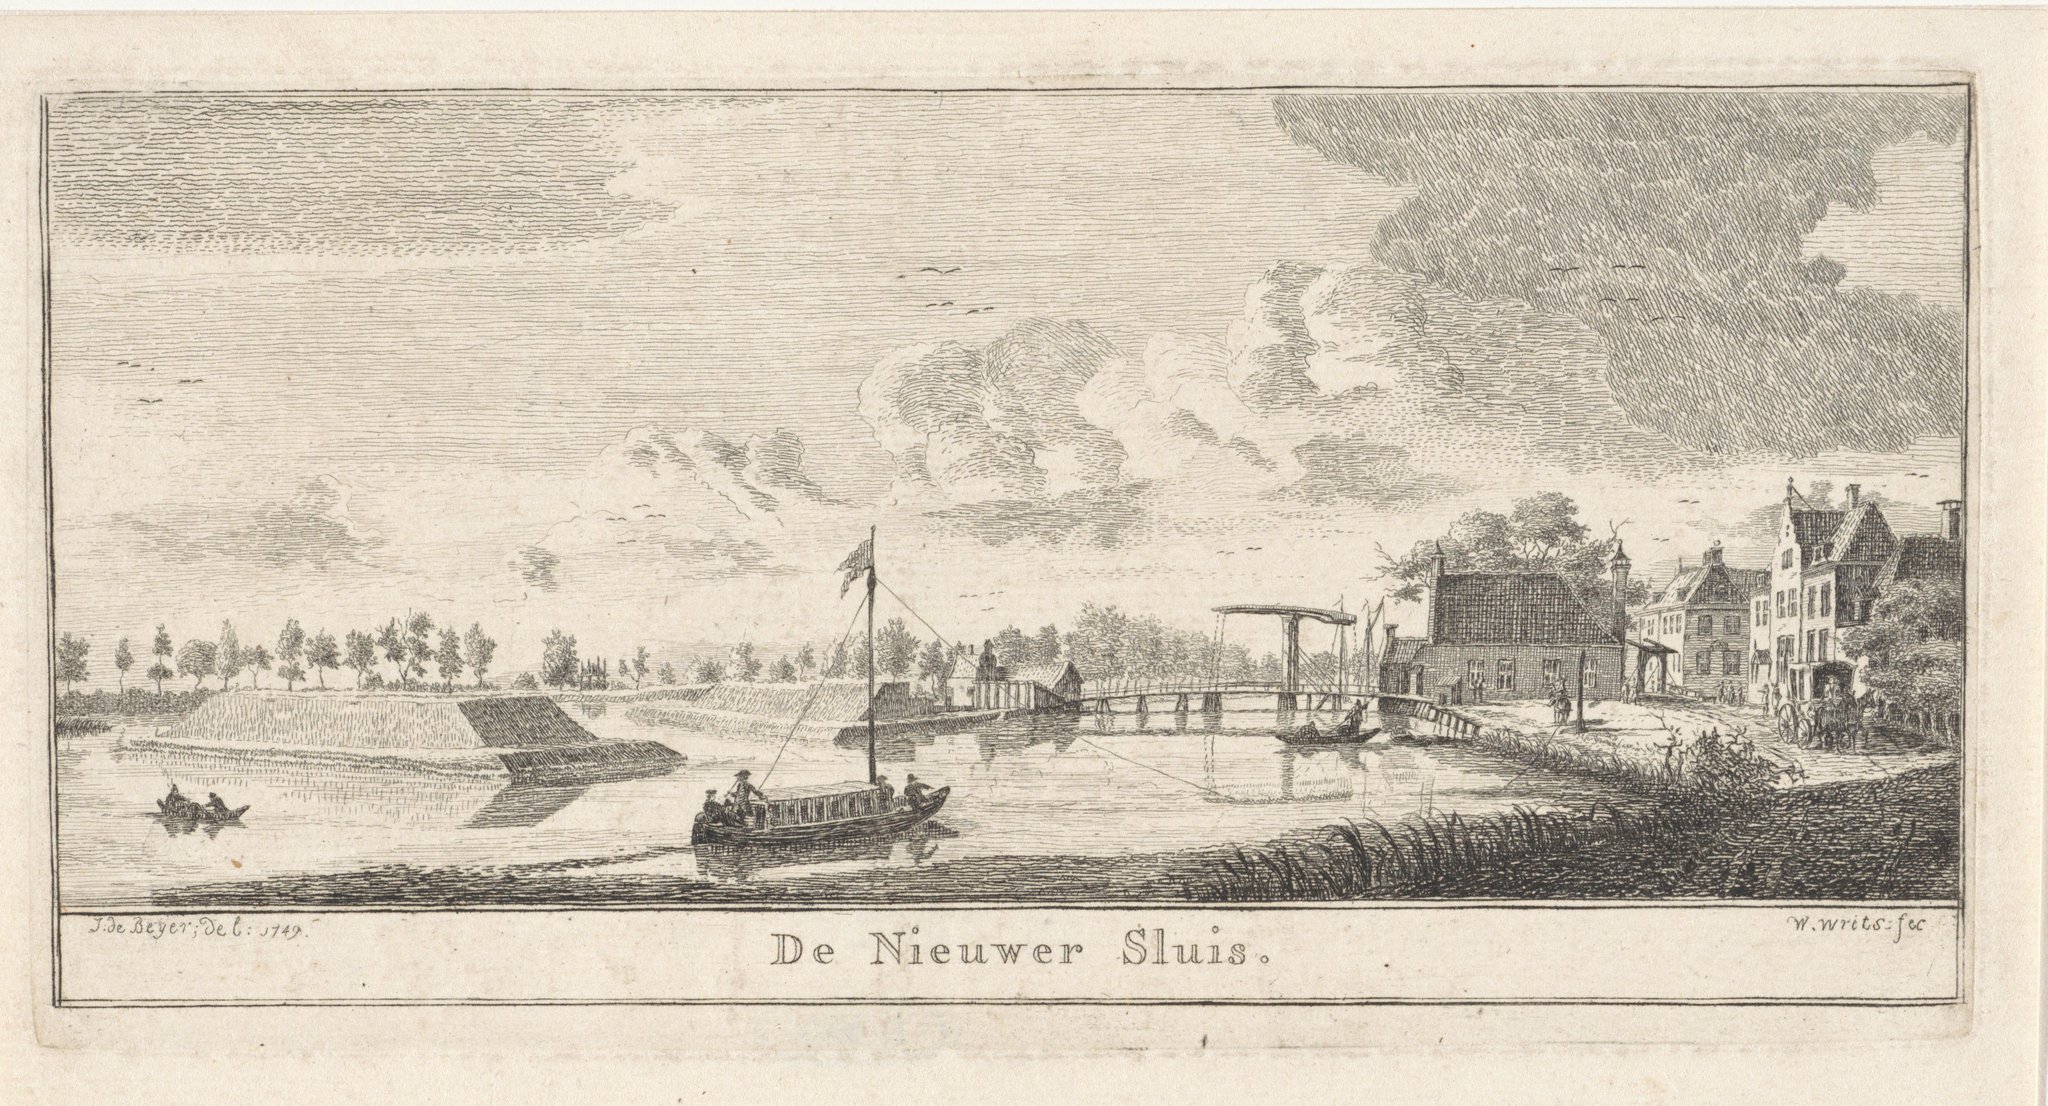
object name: print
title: Gezicht op Nieuwersluis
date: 1749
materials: paper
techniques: etching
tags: sluice, weir, boat propelled by man or animal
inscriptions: collector's mark: Lugt 2228